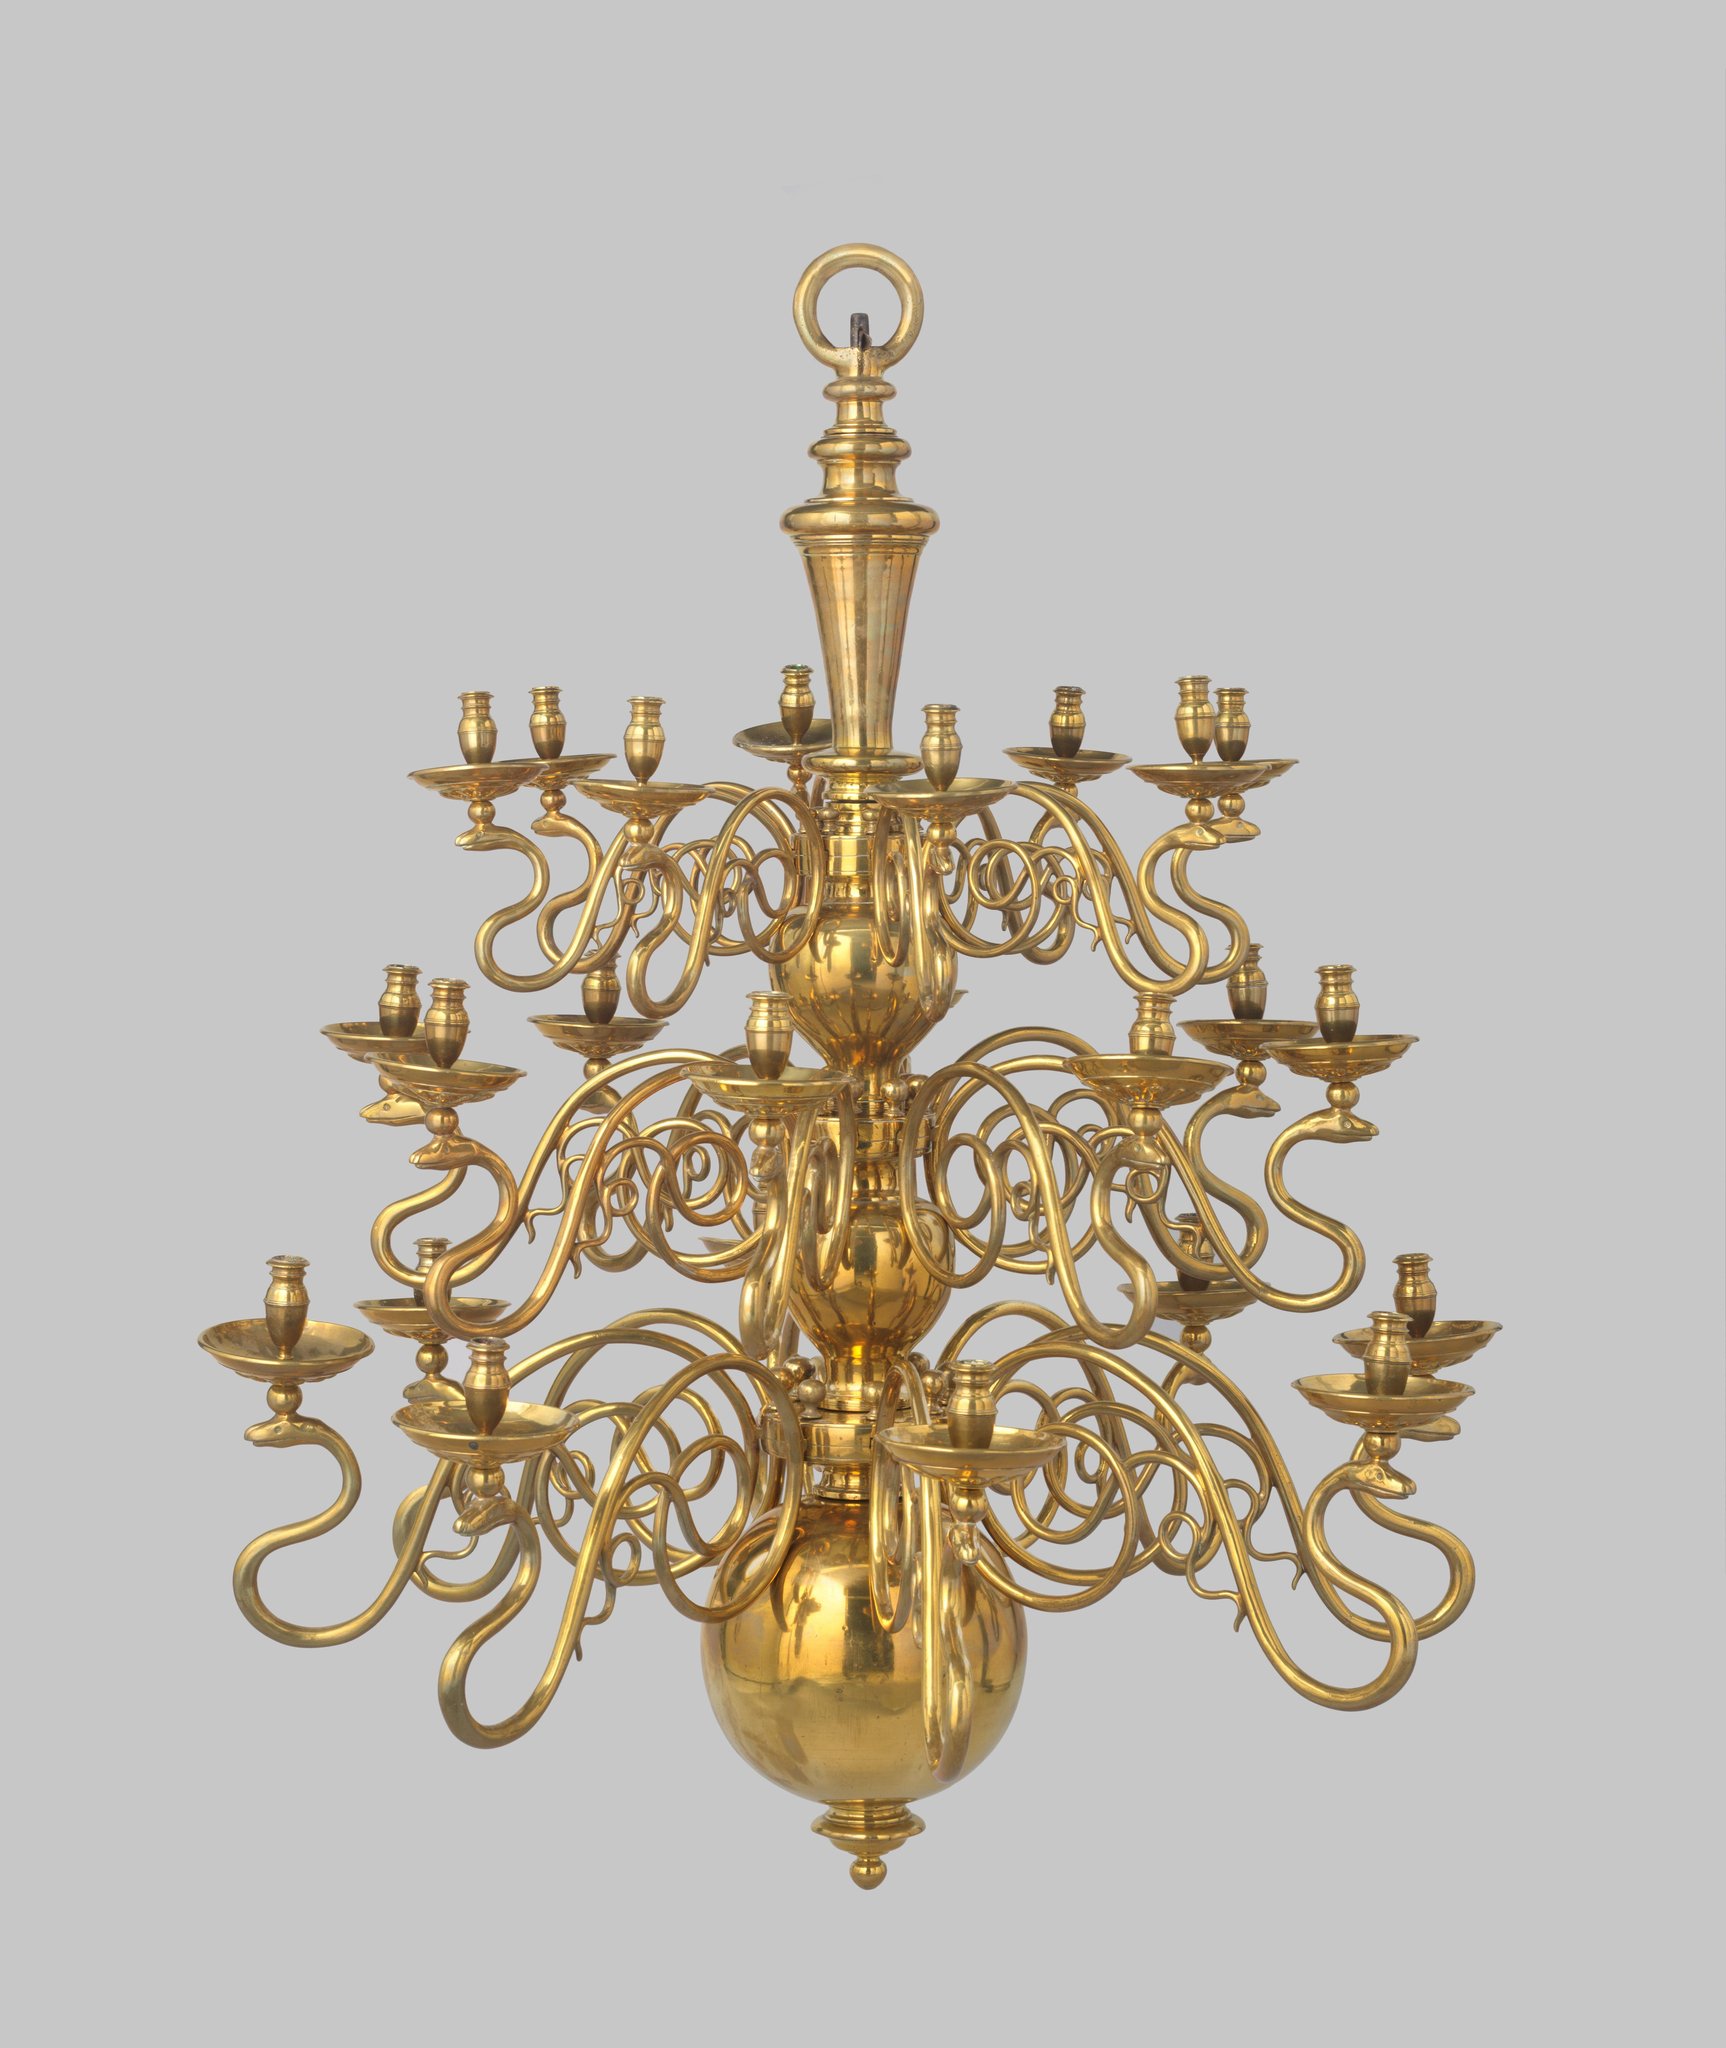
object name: chandelier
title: Arm van een kaarsenkroon in drie hoogten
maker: Anonymous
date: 1625-1650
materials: brass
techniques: casting, screwed, turning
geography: northern netherlands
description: De arm is aan de stamzijde voorzien van een nok, waarin een gat is aangebracht om ze met een pin in de standringen te kunnen vastzetten. De S-vormige arm heeft de gedaante van een slang met een naar de stamzijde gekronkelde staart en naar buiten toe een opgeheven kop met daarop een ronde knop, waarin het van een schroefdraad voorziene gat is aangebracht ter bevestiging van de kaarsenhouders met de vetvangers. De arm is met behulp van hetzelfde model gegoten als de overige armen van de krans. De ronde kaarsenhouder is vaasvormig met een geprofileerde rib. Bovenaan heeft zij twee holronde profileringen, en een uitkragende rand en onderaan een uit twee holronde profileringen bestaande voet. De voet loopt uit in een zich verjongend schroefeind met een centergat. De bolle vetvanger is aan de bovenkant glad en heeft aan de onderkant visblaasachtige godrons en een rib. De vetvanger is met behulp van hetzelfde model gegoten als de overige vetvangers van de krans. De pinnen zijn met bolle knoppen versierd. Dit is de zevende arm van de bovenste standring, genummerd op de nok met het cijfer VII.